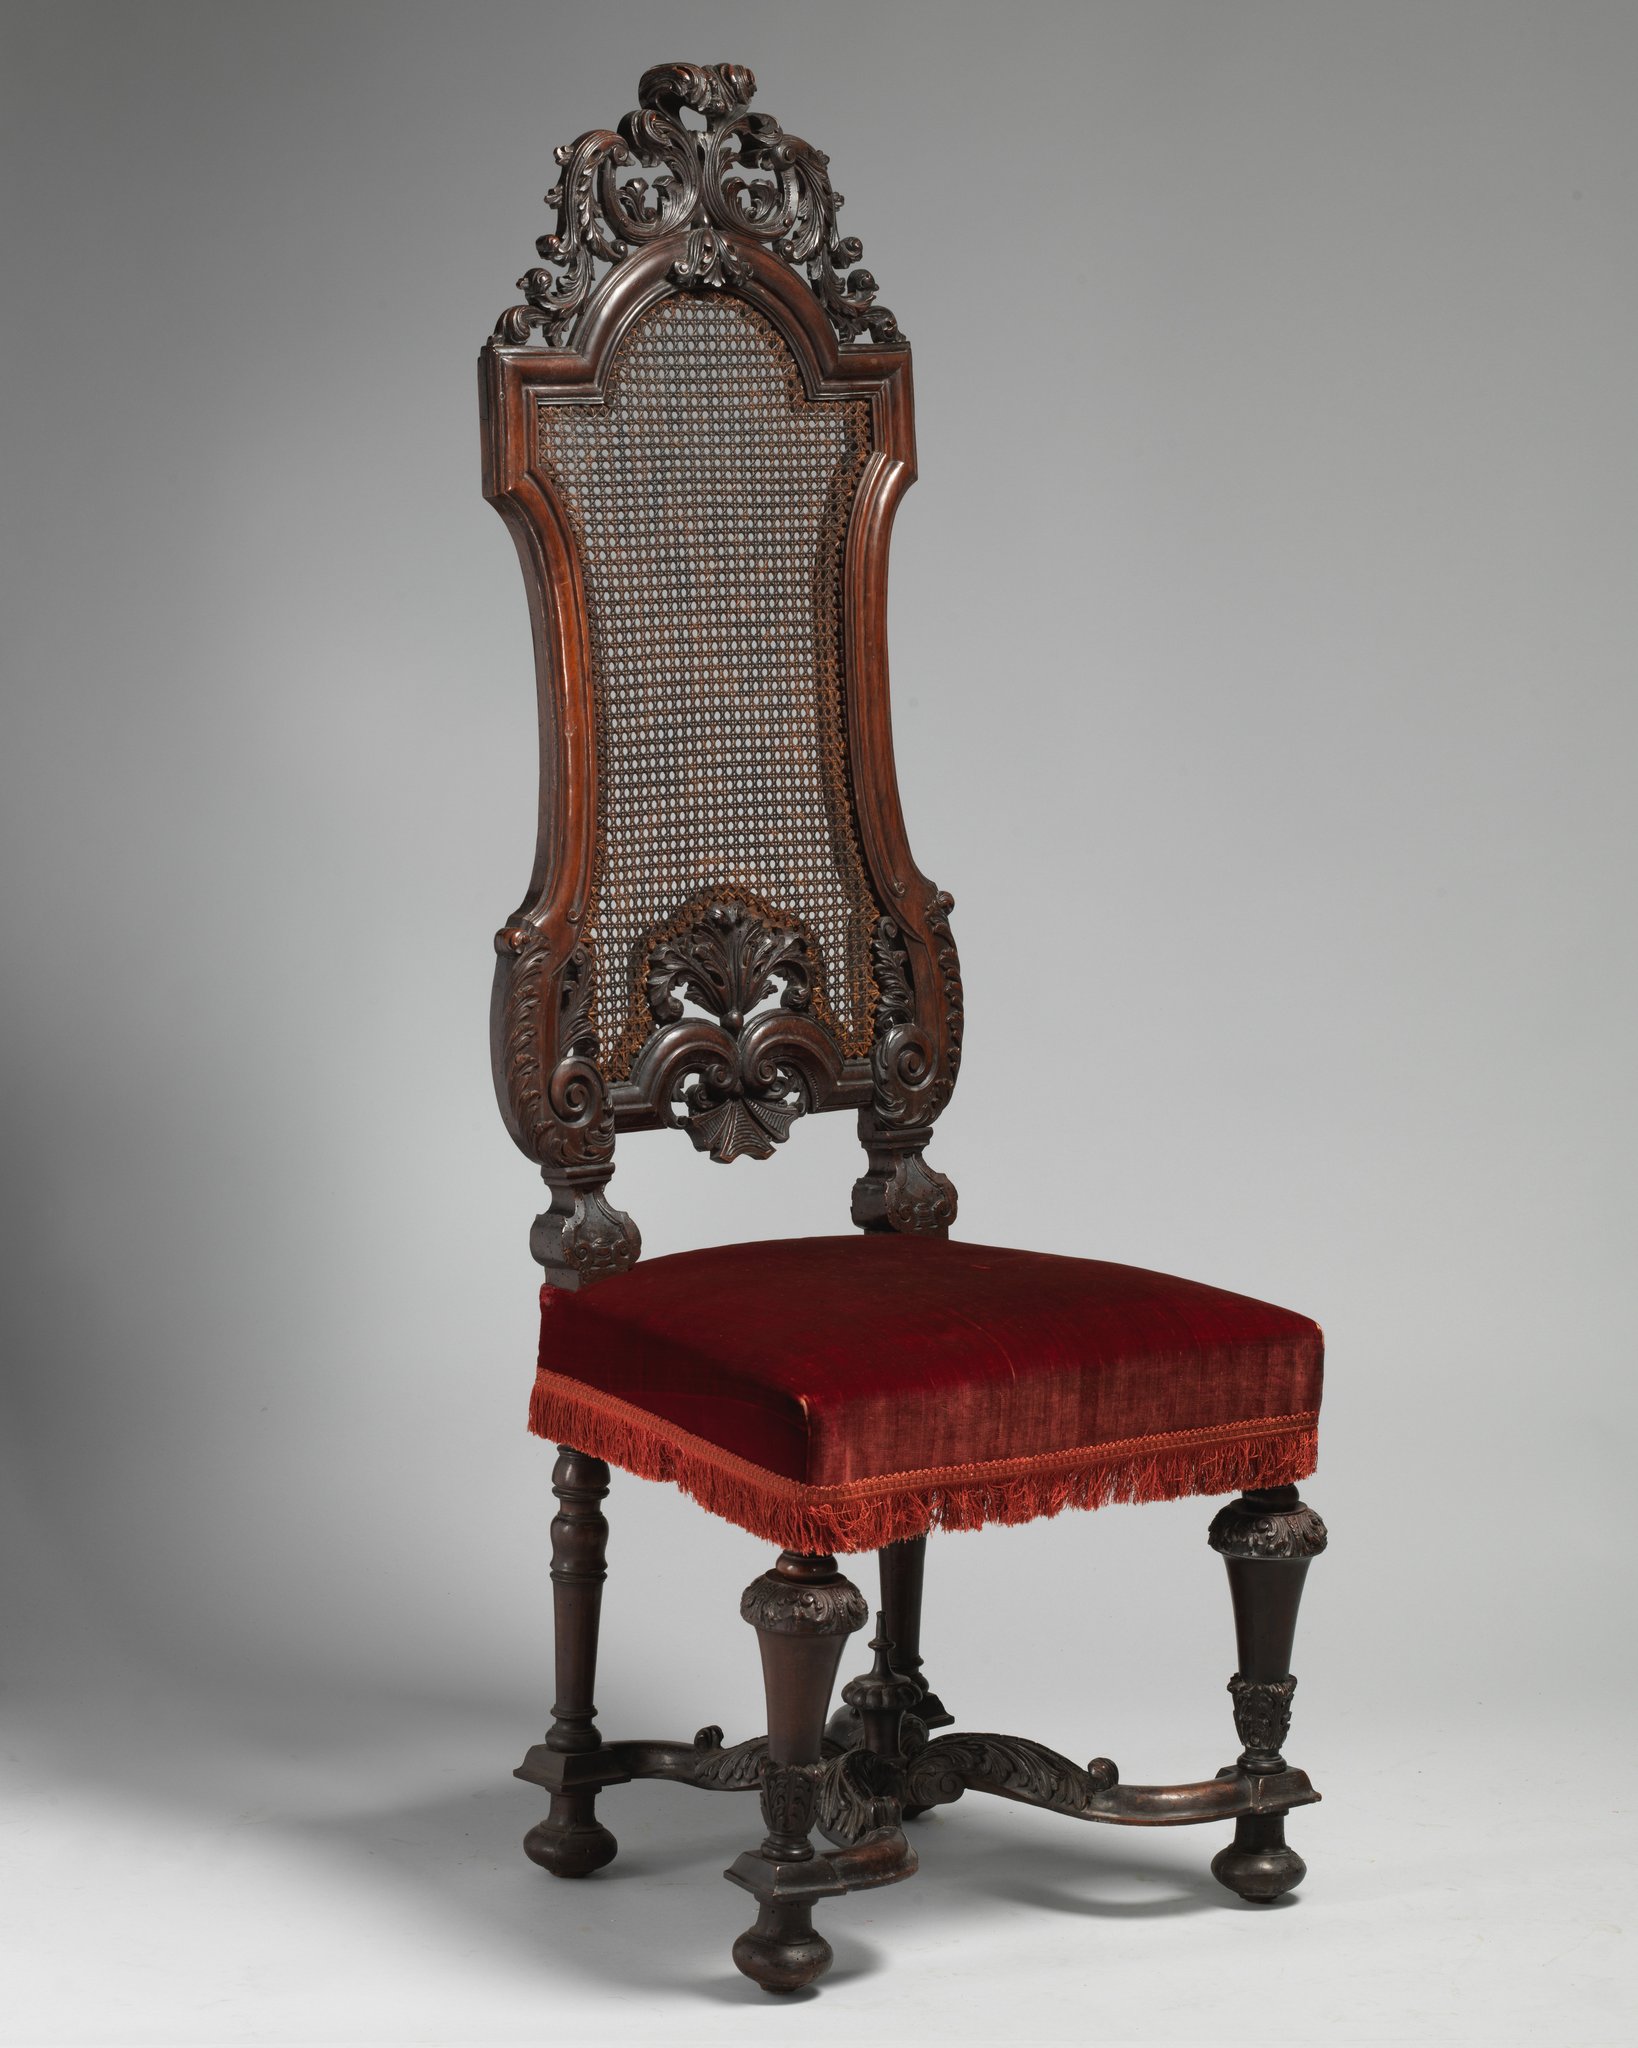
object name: chair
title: Chair (one of a set of six)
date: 1695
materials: velvet, wood